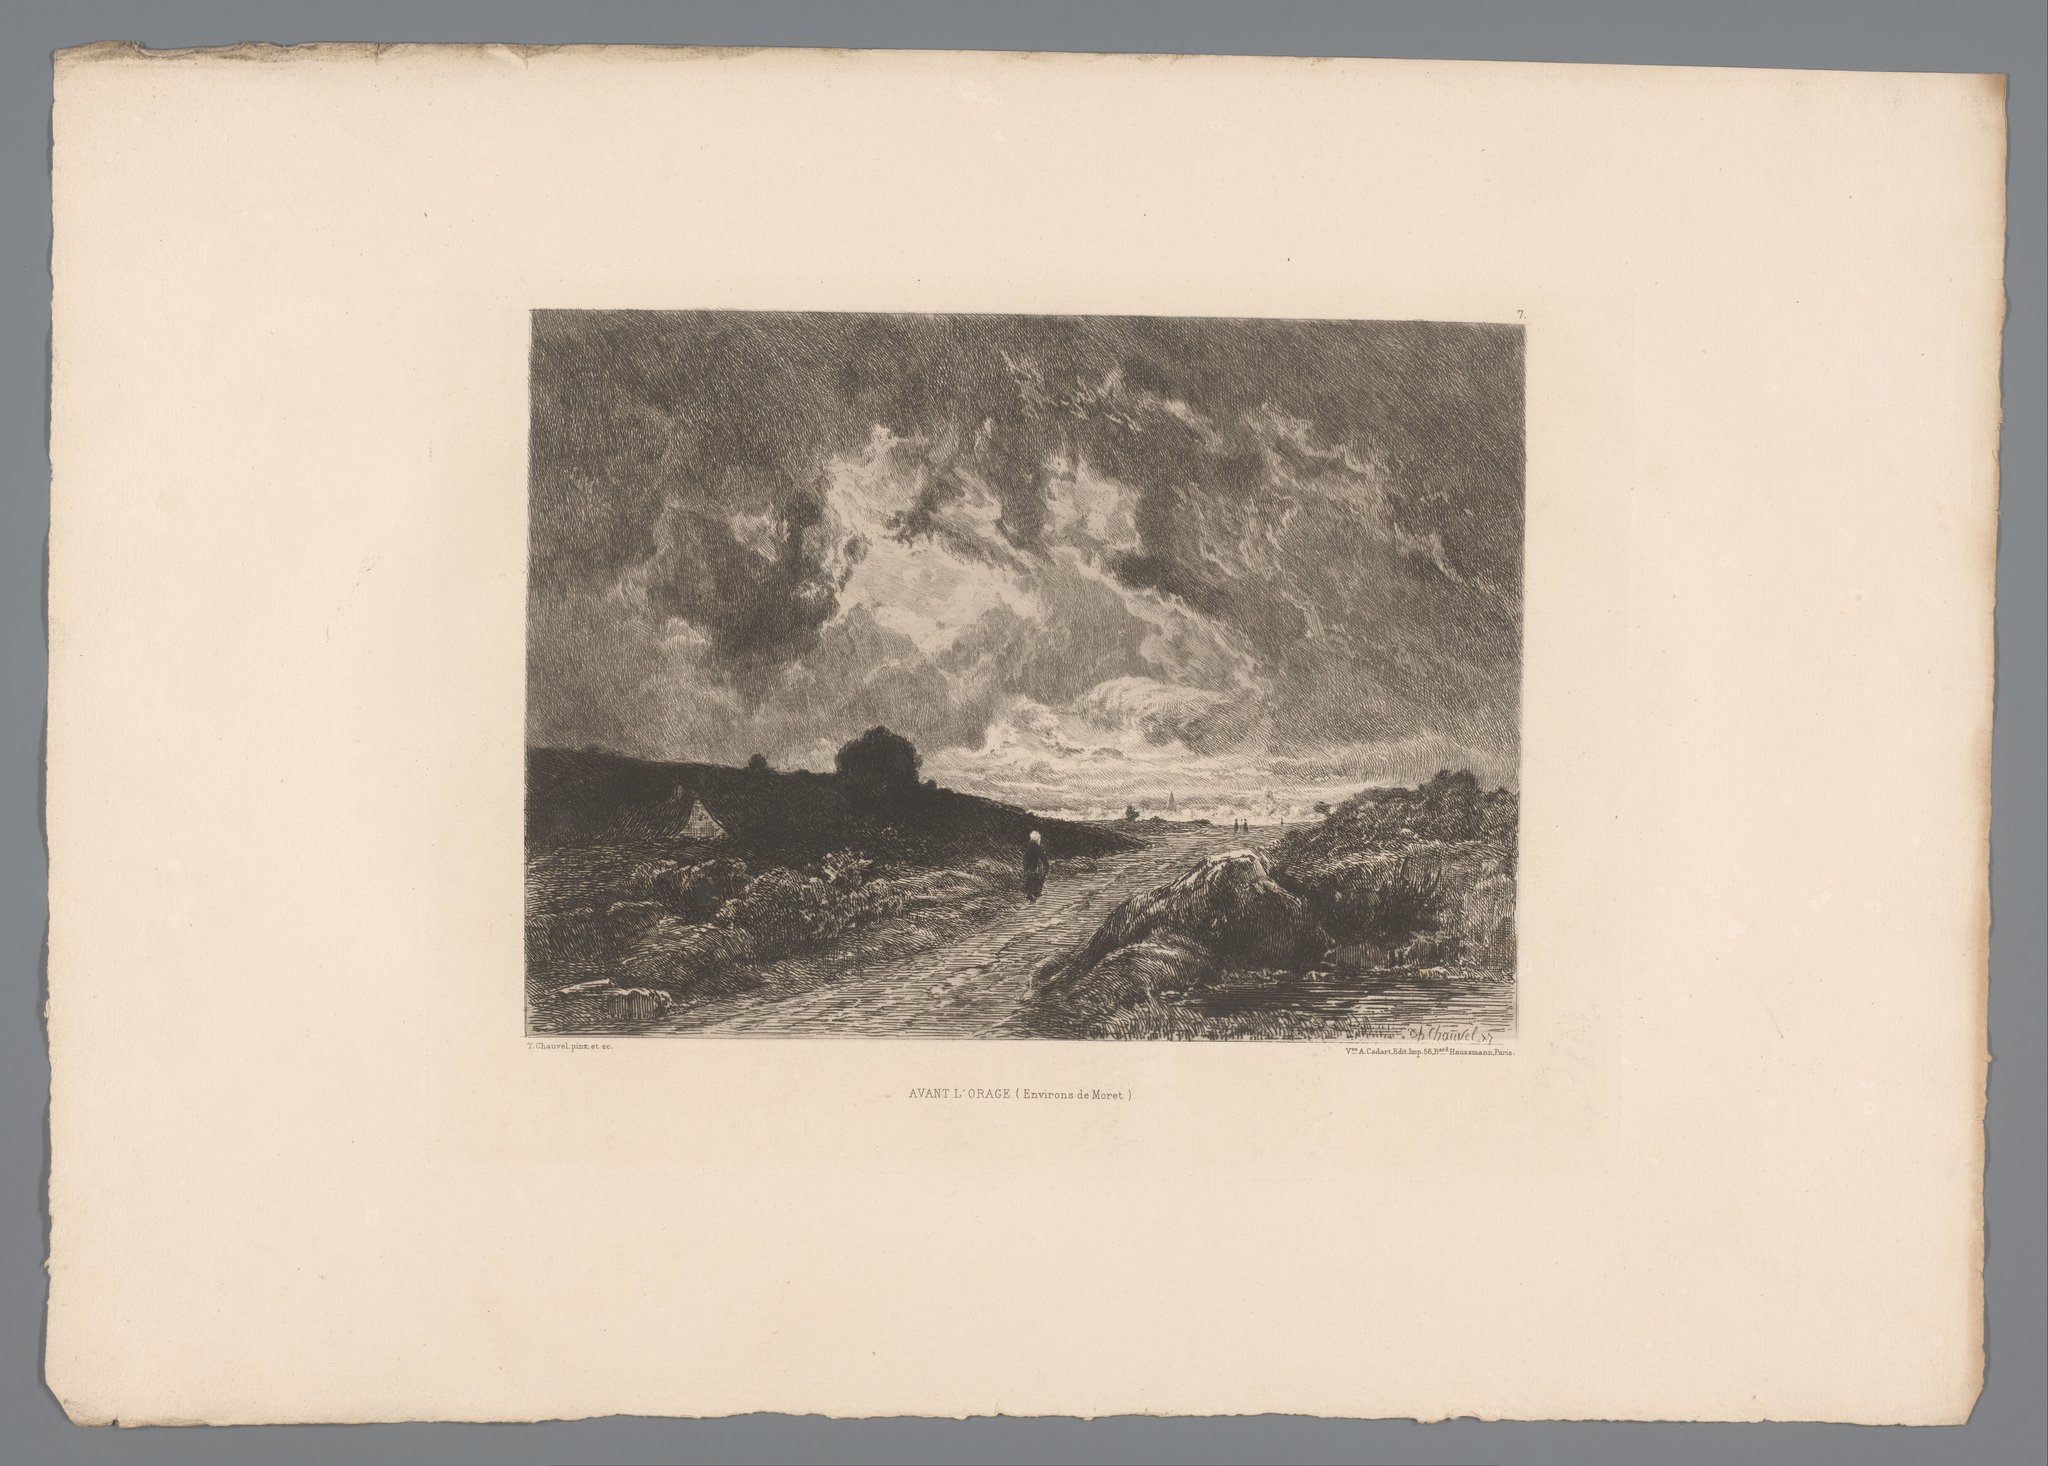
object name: print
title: Avant l'orage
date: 1878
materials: paper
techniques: drypoint, etching, intaglio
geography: paris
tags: landscapes, storm on land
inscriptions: watermark, collector's mark: Lugt 2228, collector's mark: ‘AFE v S’, collector's mark: Lugt 2760